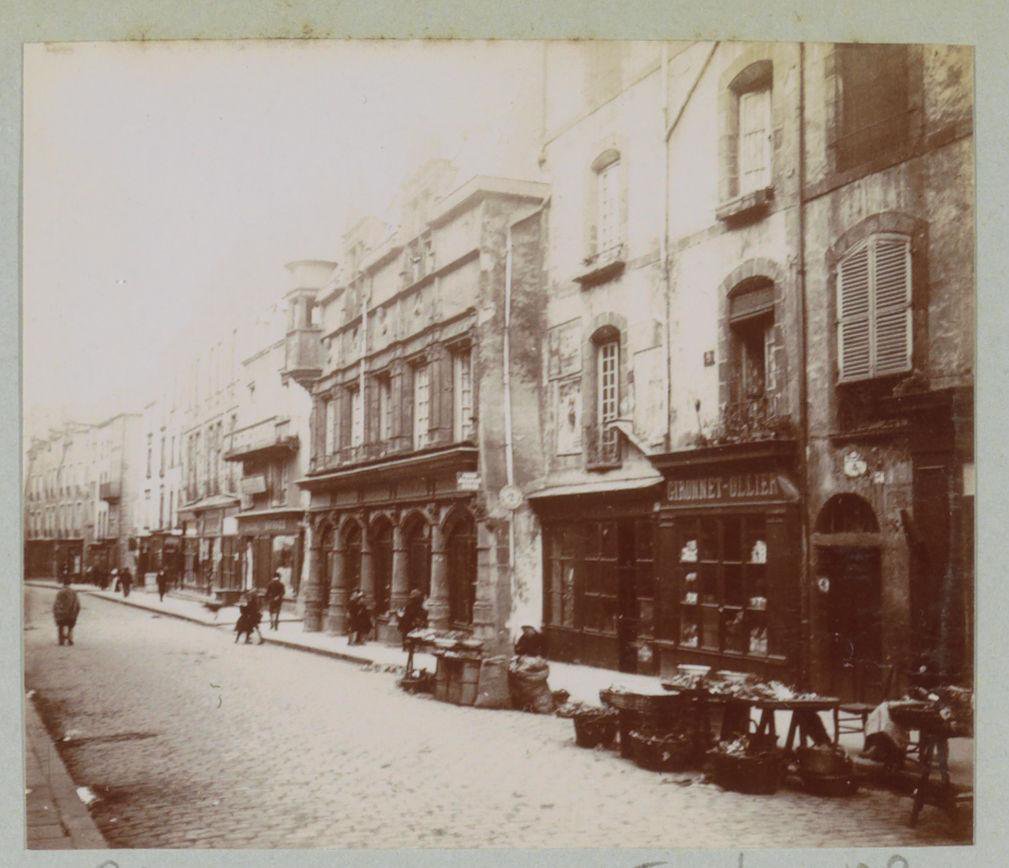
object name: photograph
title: Straat in Riom met winkels en voorbijgangers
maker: delizy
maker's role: manufacturer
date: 1902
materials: paper, photographic support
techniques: gelatin silver print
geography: josselin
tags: shop, store, street (+ city(-scape) with figures, staffage)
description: Onderdeel van Fotoalbum van een Franse amateurfotograaf met opnames van uitstapjes in Frankrijk, Spanje, België, Luxemburg en Nederland, de eerste automobielen en autoraces.